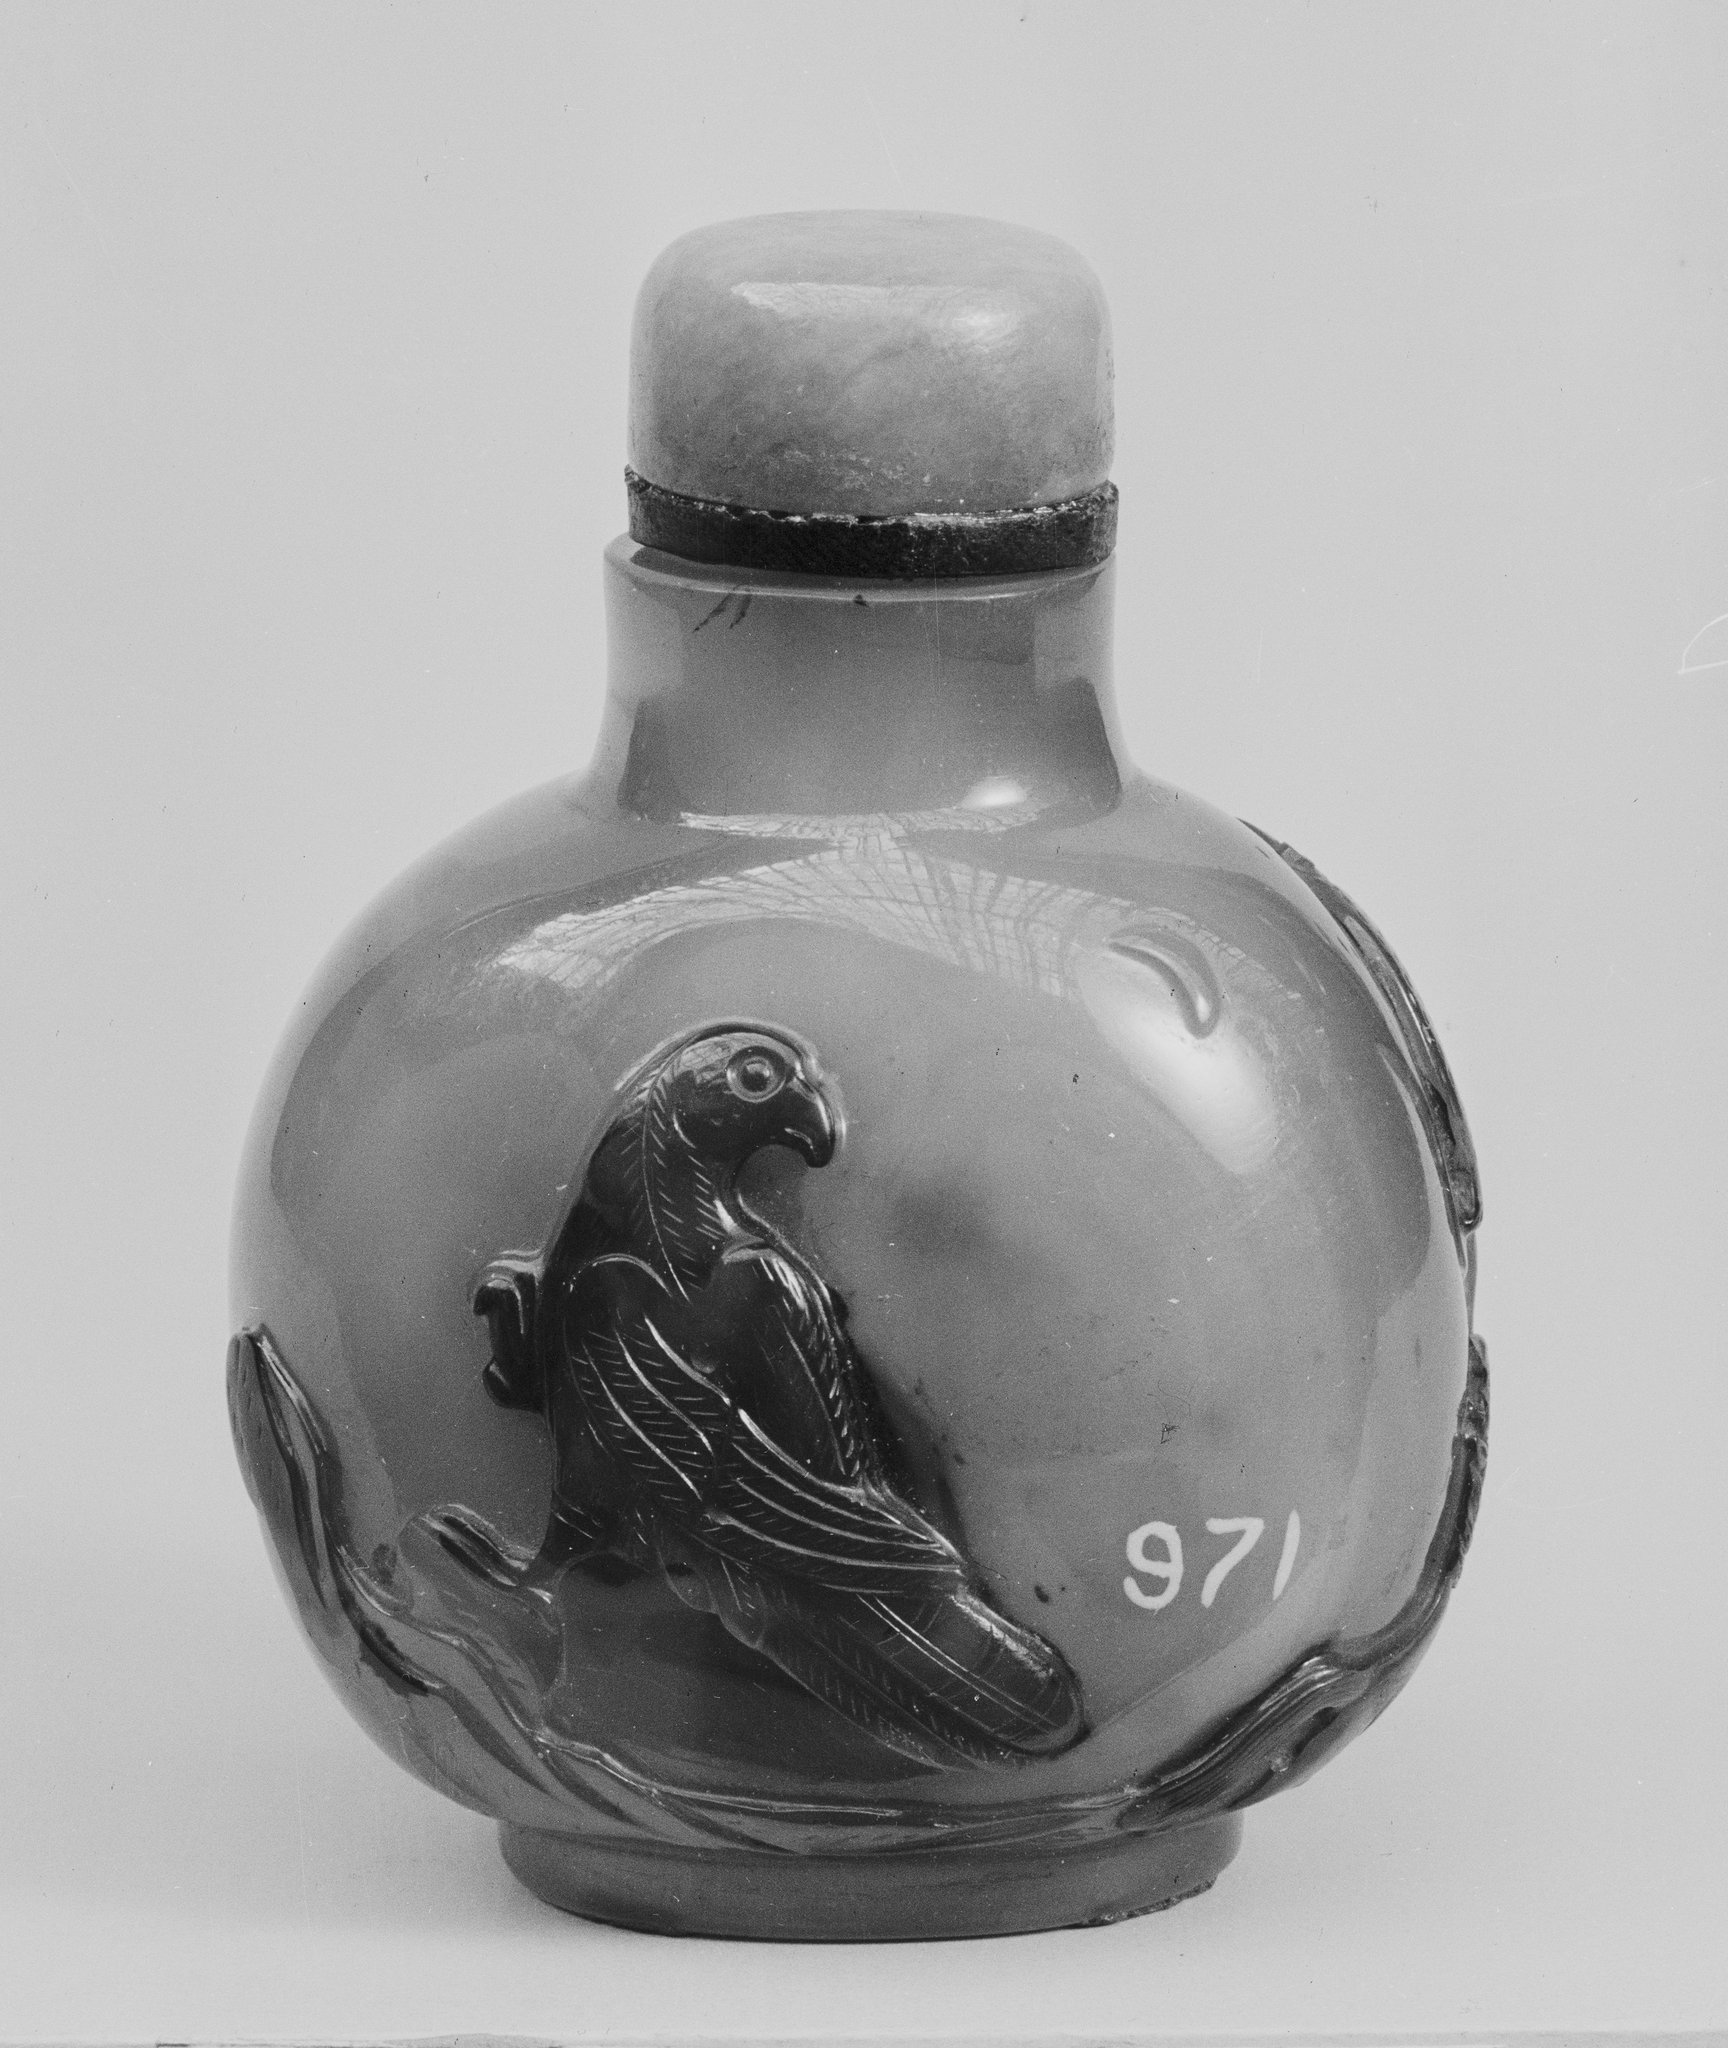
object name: snuff bottle with stopper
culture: chinese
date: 1701-1900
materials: stone, jade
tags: eagles